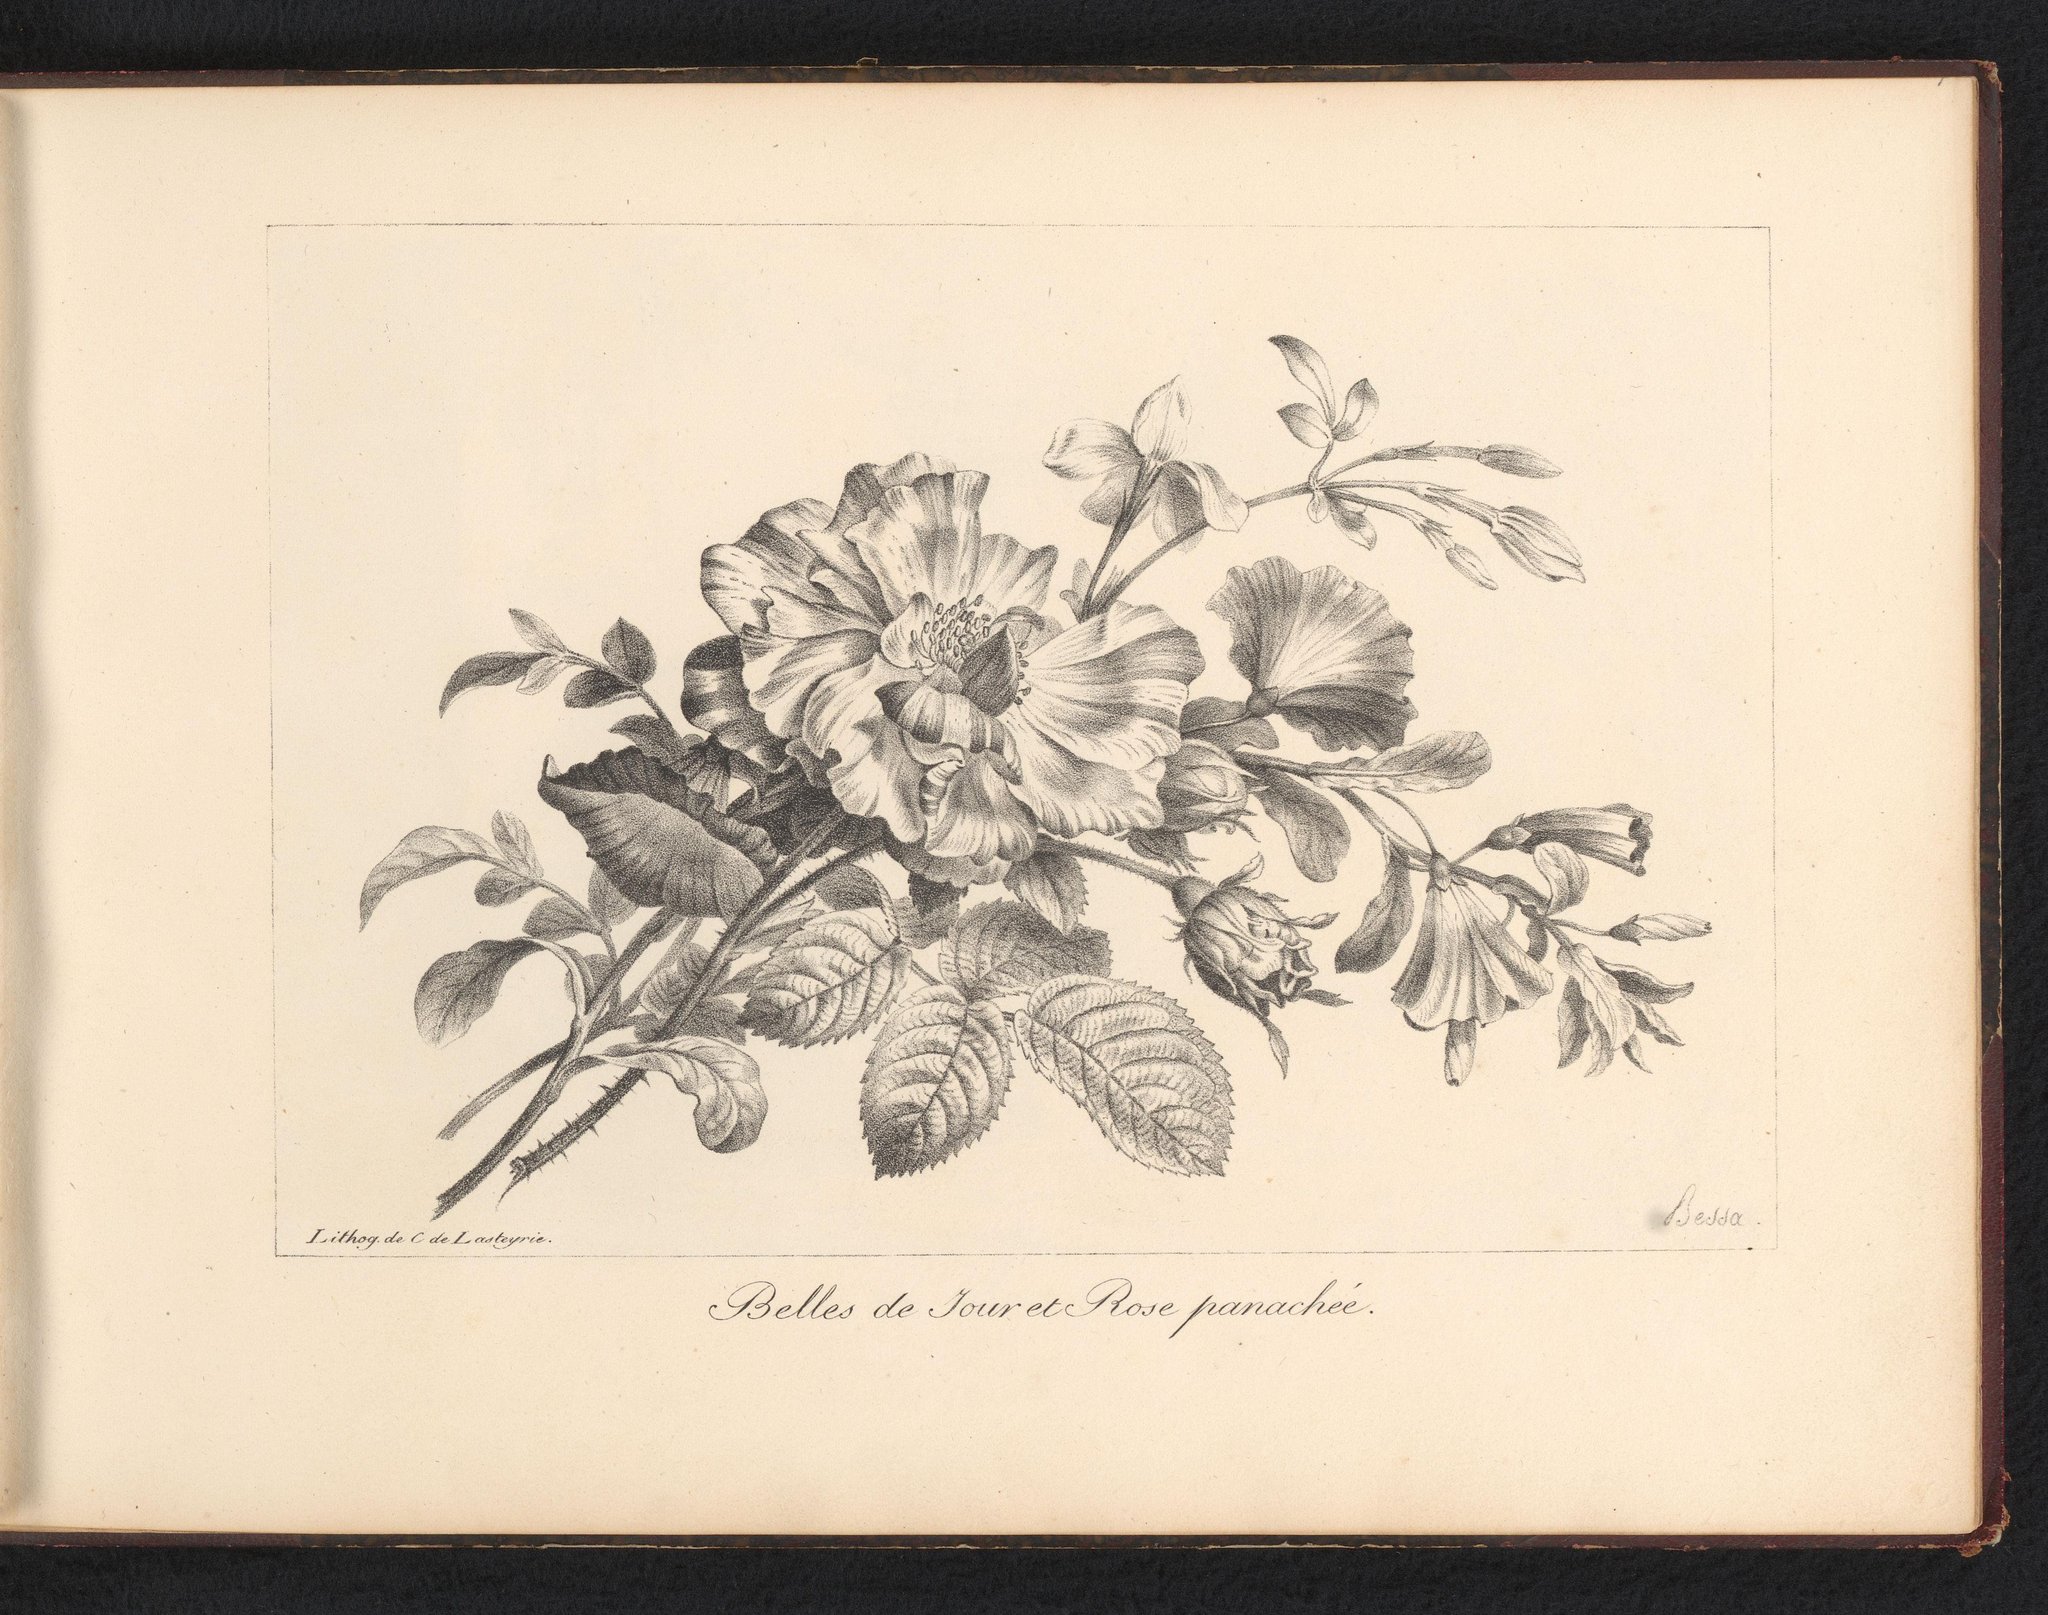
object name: print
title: Belles de Jour et Rose panachée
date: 1817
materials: paper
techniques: lithograph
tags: flowers: rose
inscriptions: collector's mark: Lugt 2228, collector's mark: Lugt 2760